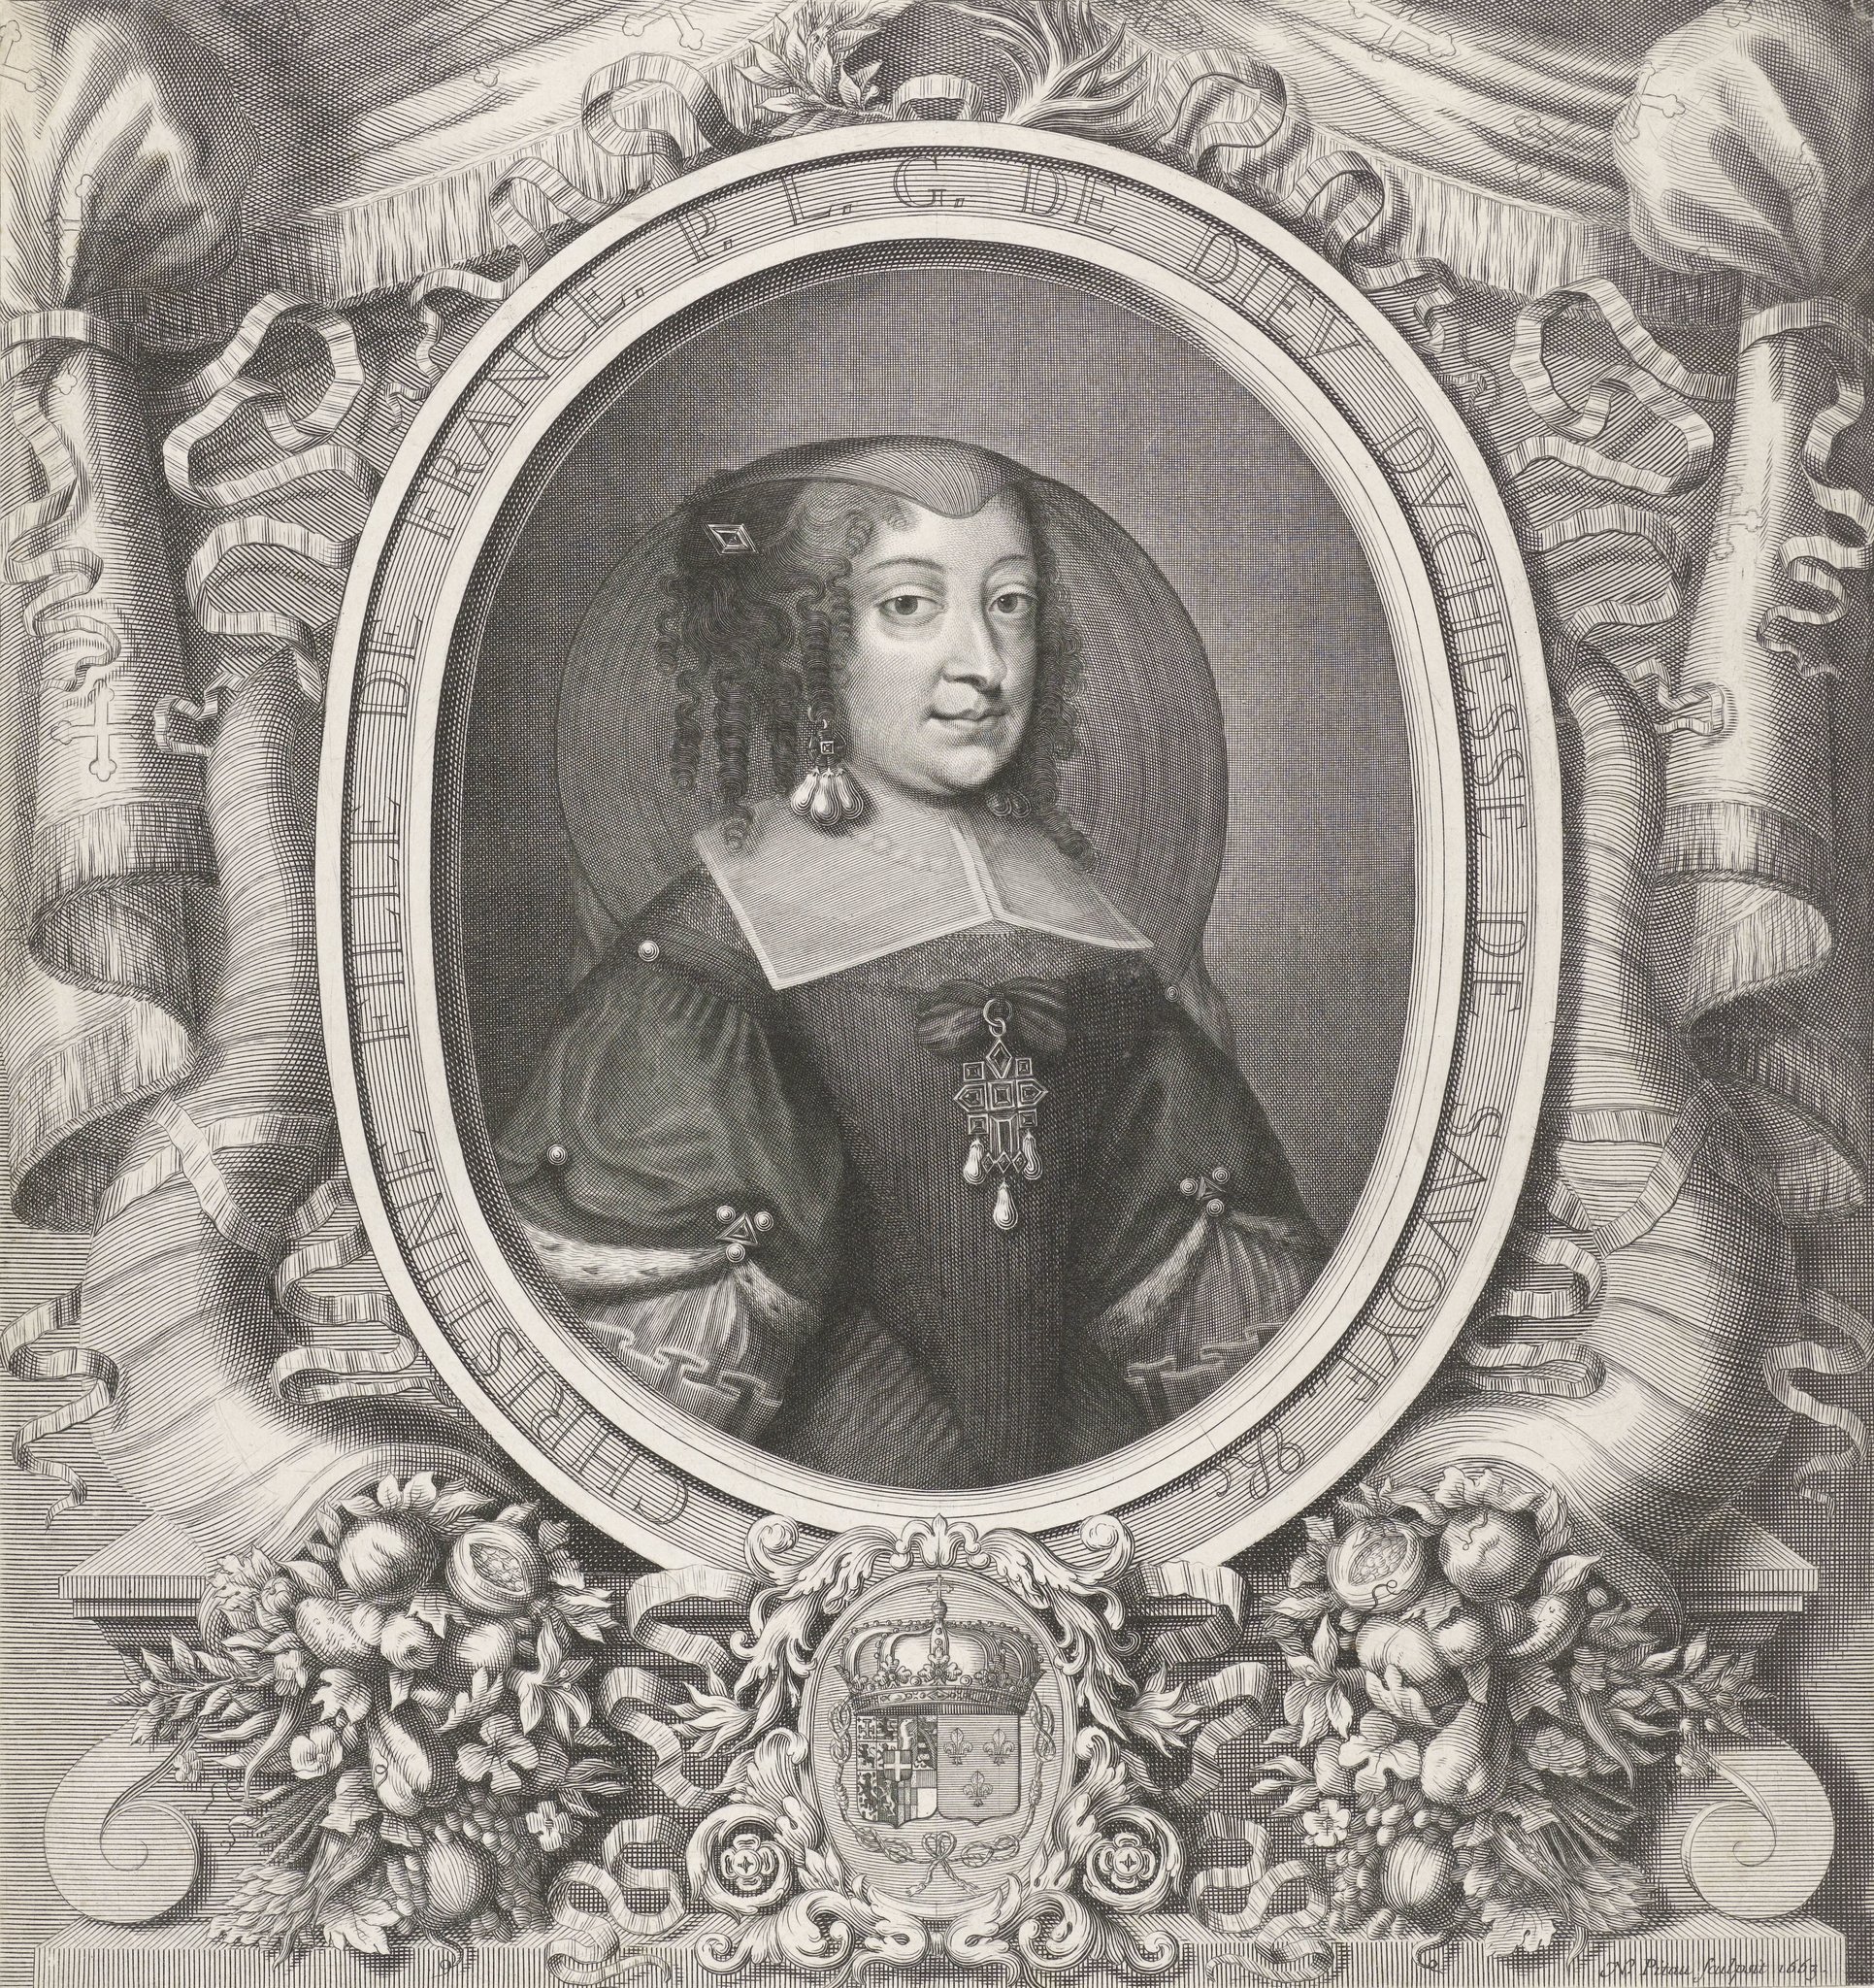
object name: print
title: Portret van Christine Marie van Frankrijk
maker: nicolas pitau (i)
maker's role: print maker, publisher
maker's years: 1632-1671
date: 1663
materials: paper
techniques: engraving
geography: paris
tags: ear-rings (+ women's clothes), 'cornucopia', horn of plenty, brooch, agraffe, clasp (+ women's clothes), veil (+ women's clothes), armorial bearing, heraldry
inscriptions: collector's mark: Lugt 2228, collector's mark: Lugt 1490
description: Portret van Christine Marie van Frankrijk, hertogin van Savoye. Het portret is gevat in een ovale omlijsting met aan weerszijden een hoorn des overvloeds. Onder de omlijsting haar wapenschild.